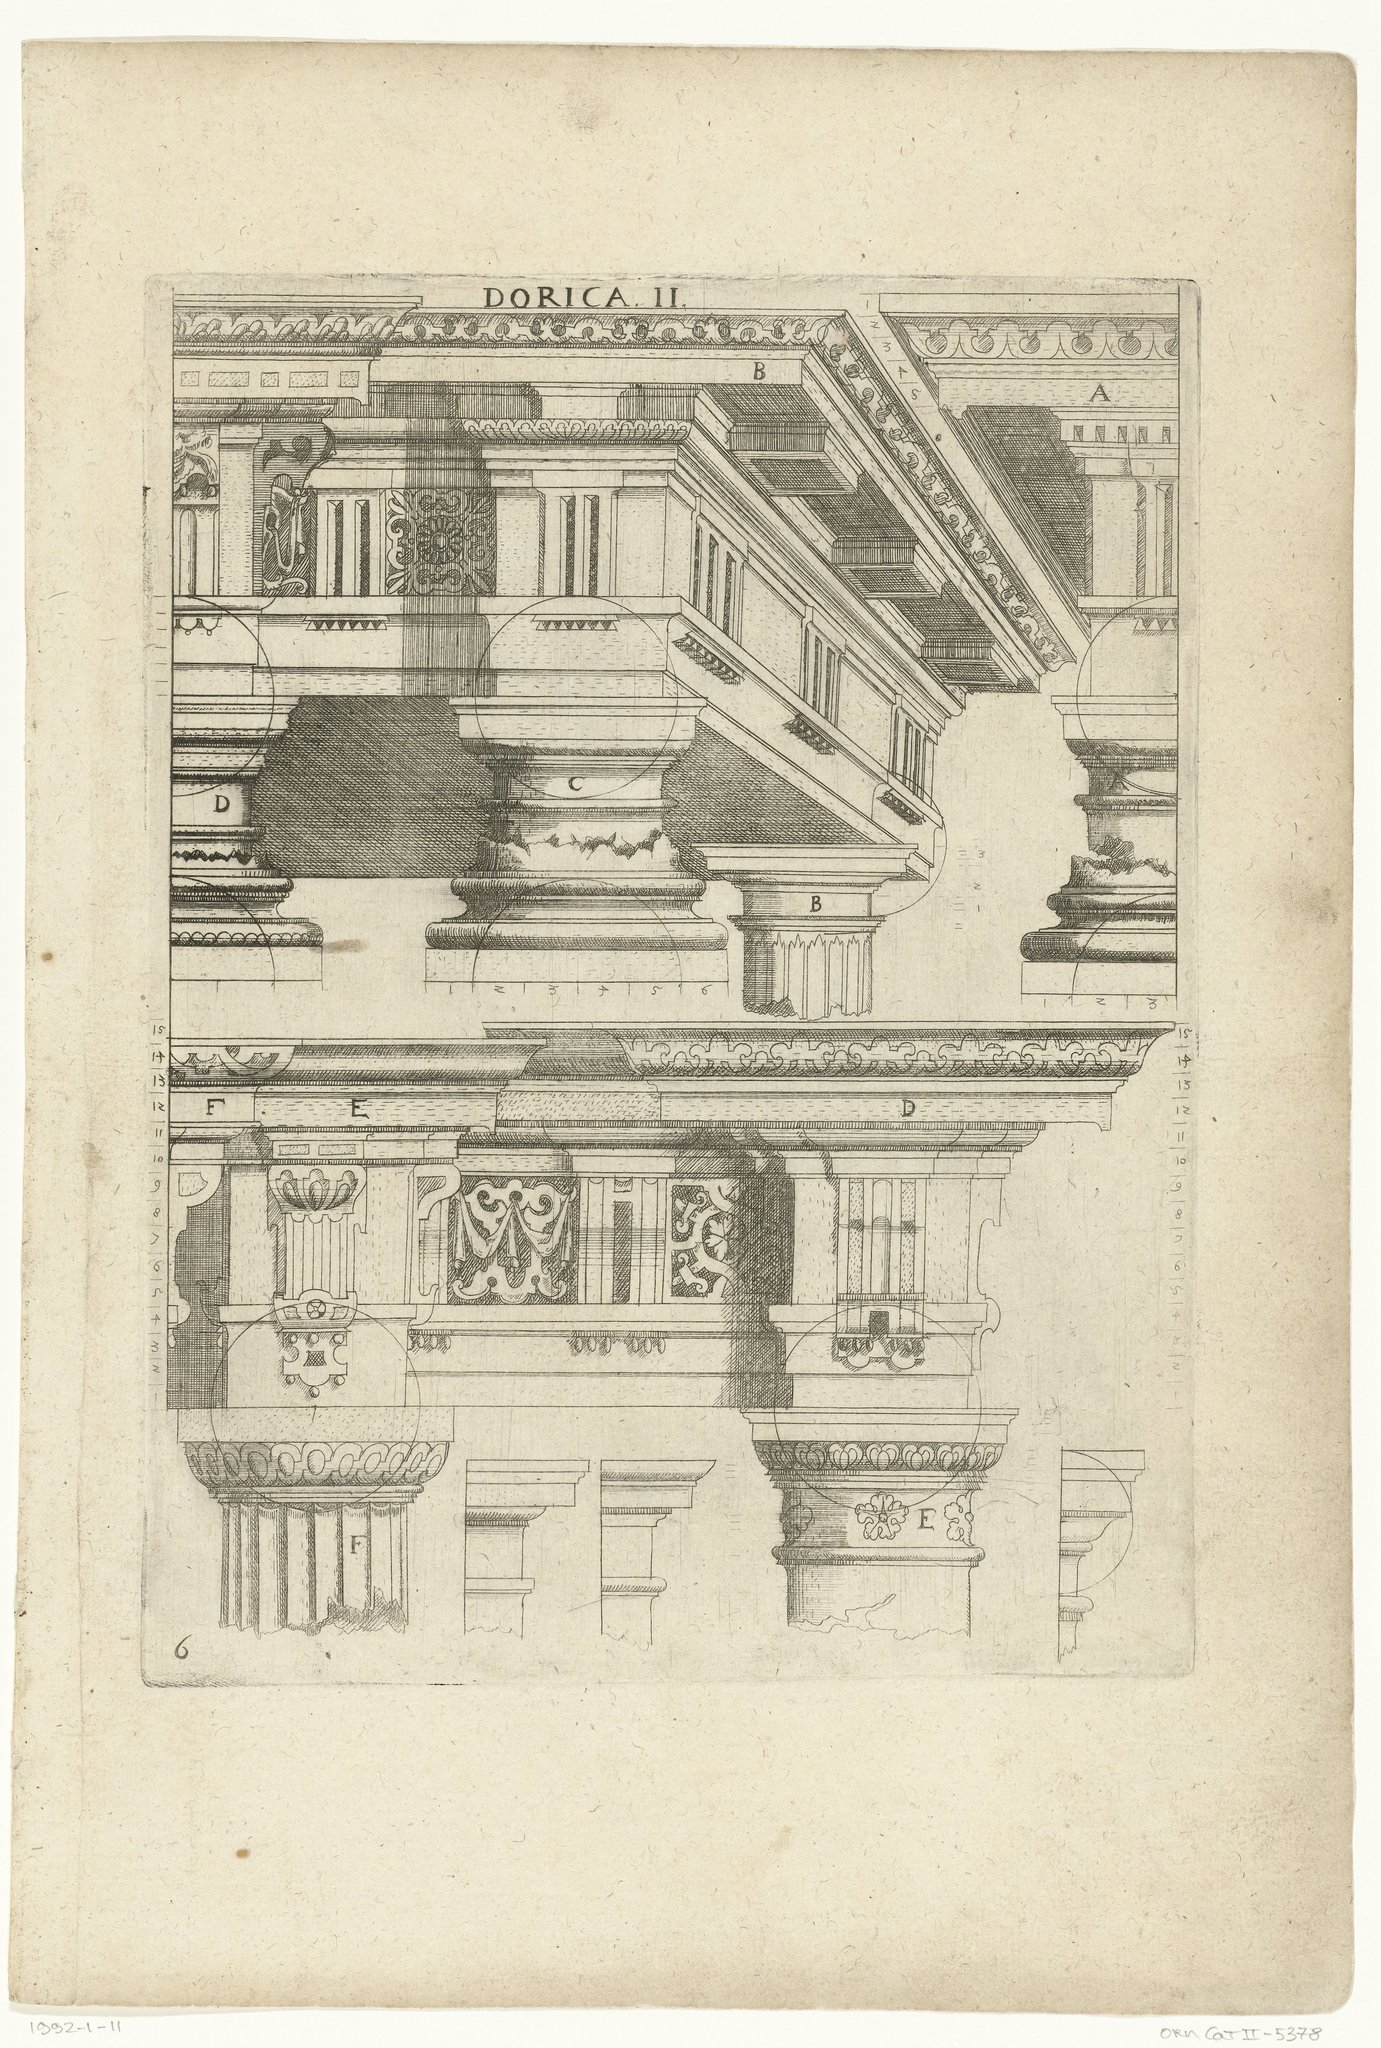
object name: print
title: Zes hoofdgestellen met doorsneden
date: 1610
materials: paper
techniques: etching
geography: cologne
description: De hoofdgestellen zijn genummerd: A-F. Blad 6 uit serie van titelblad en 28 bladen.